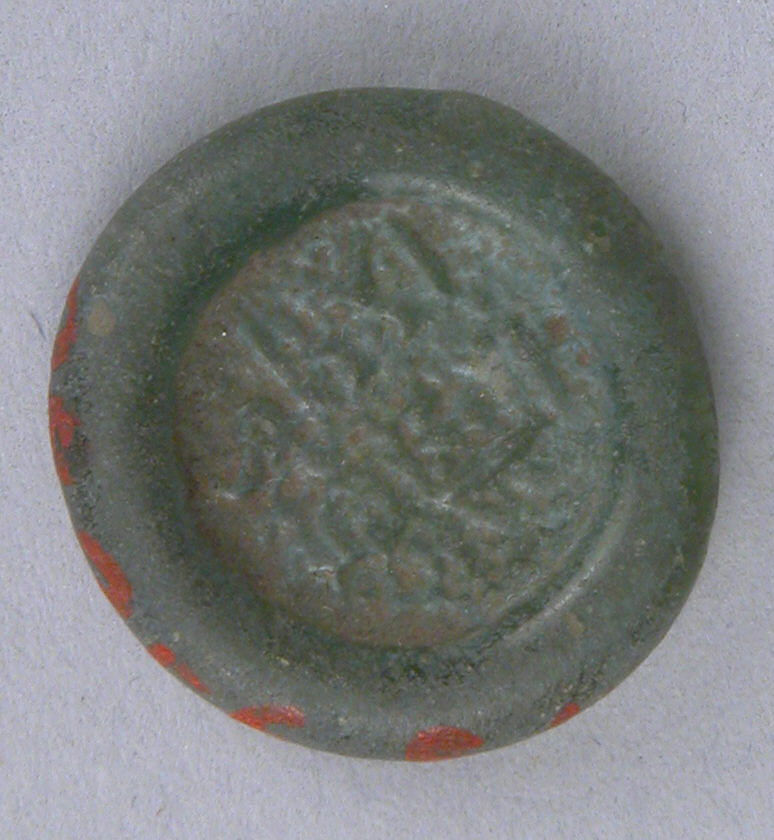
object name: coin weight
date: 1001-1100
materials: glass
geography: egypt